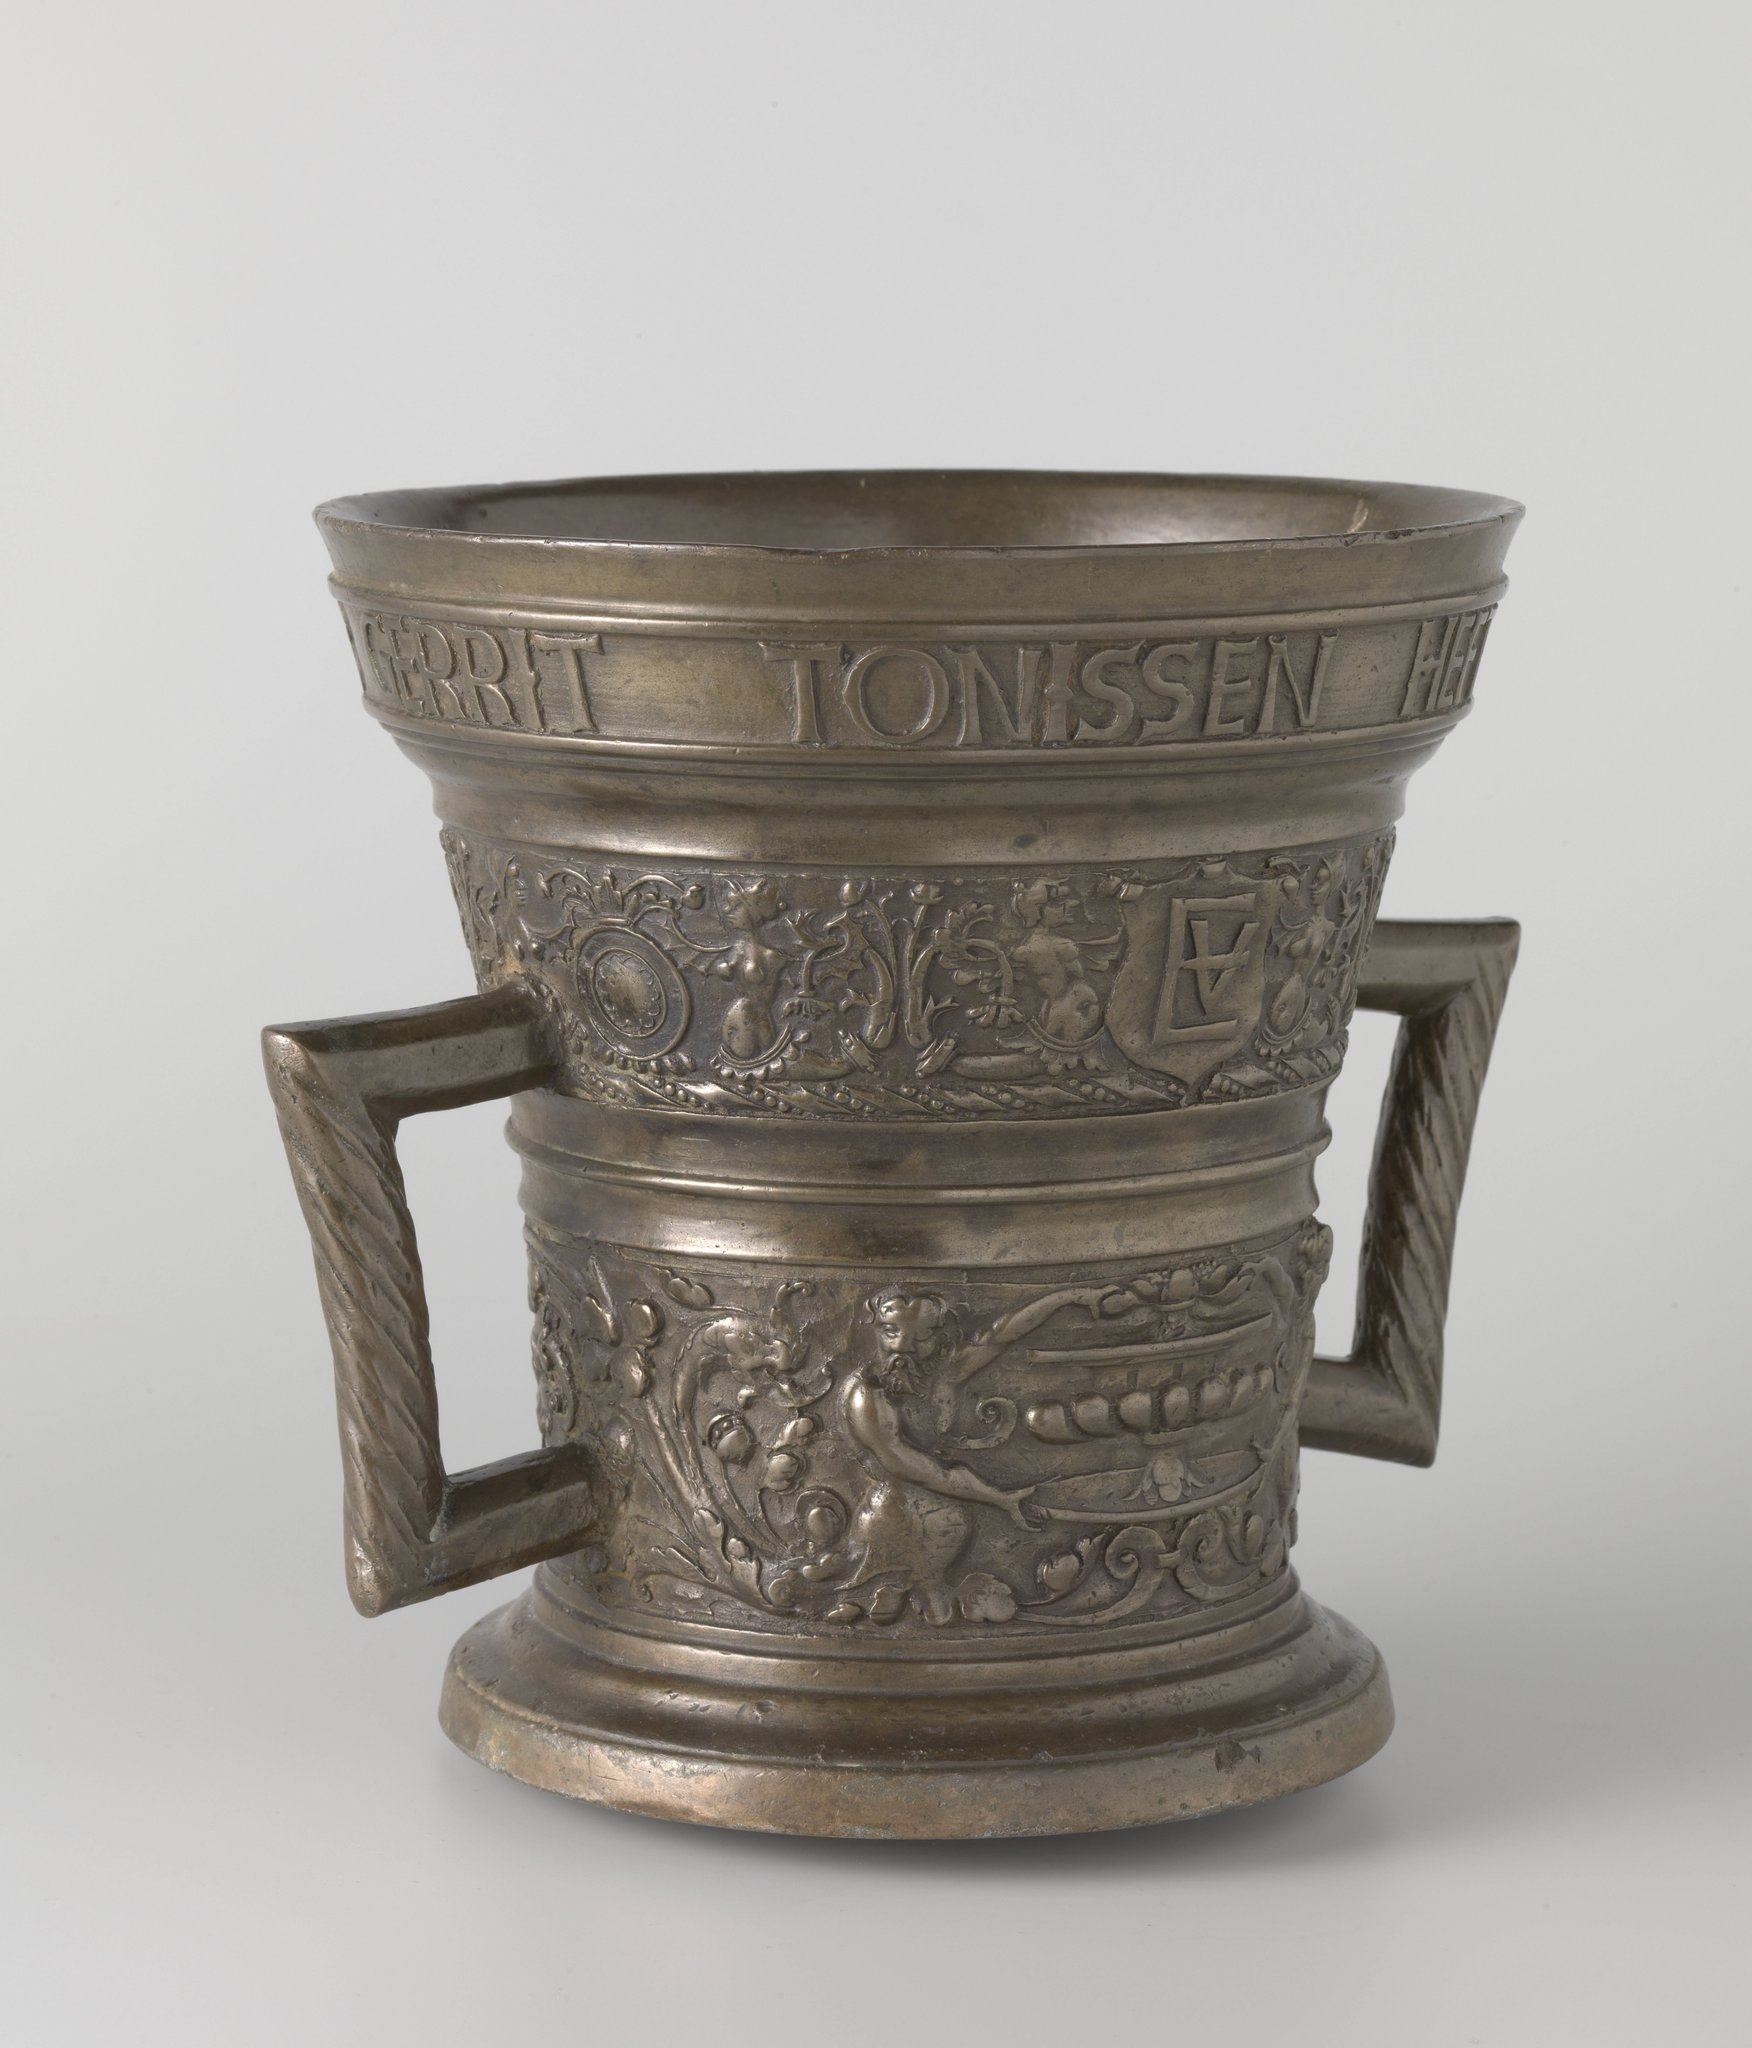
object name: mortar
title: Vijzel met opschrift: GERRIT TONISSEN HEFT MI LATEN GIETEN Ao 1568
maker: willem wegewart (i)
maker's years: 1520-1600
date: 1568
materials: bronze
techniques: casting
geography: deventer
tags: anthropomorphic ornament, ram's head ~ ornament, ornament derived from plant forms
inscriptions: inscription: ‘GERRIT TONISSEN HEFT MI LATEN GIETEN Ao 1568’, monogram: ‘EV’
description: Mortar and pestle with inscription: GERRIT TONISSEN HEFT MI LATEN GIETEN Ao 1568. (Gerrit Tonissen had me cast Ao 1568). Bronze. Deventer, 1568, Willem Wegewart the Elder (?).